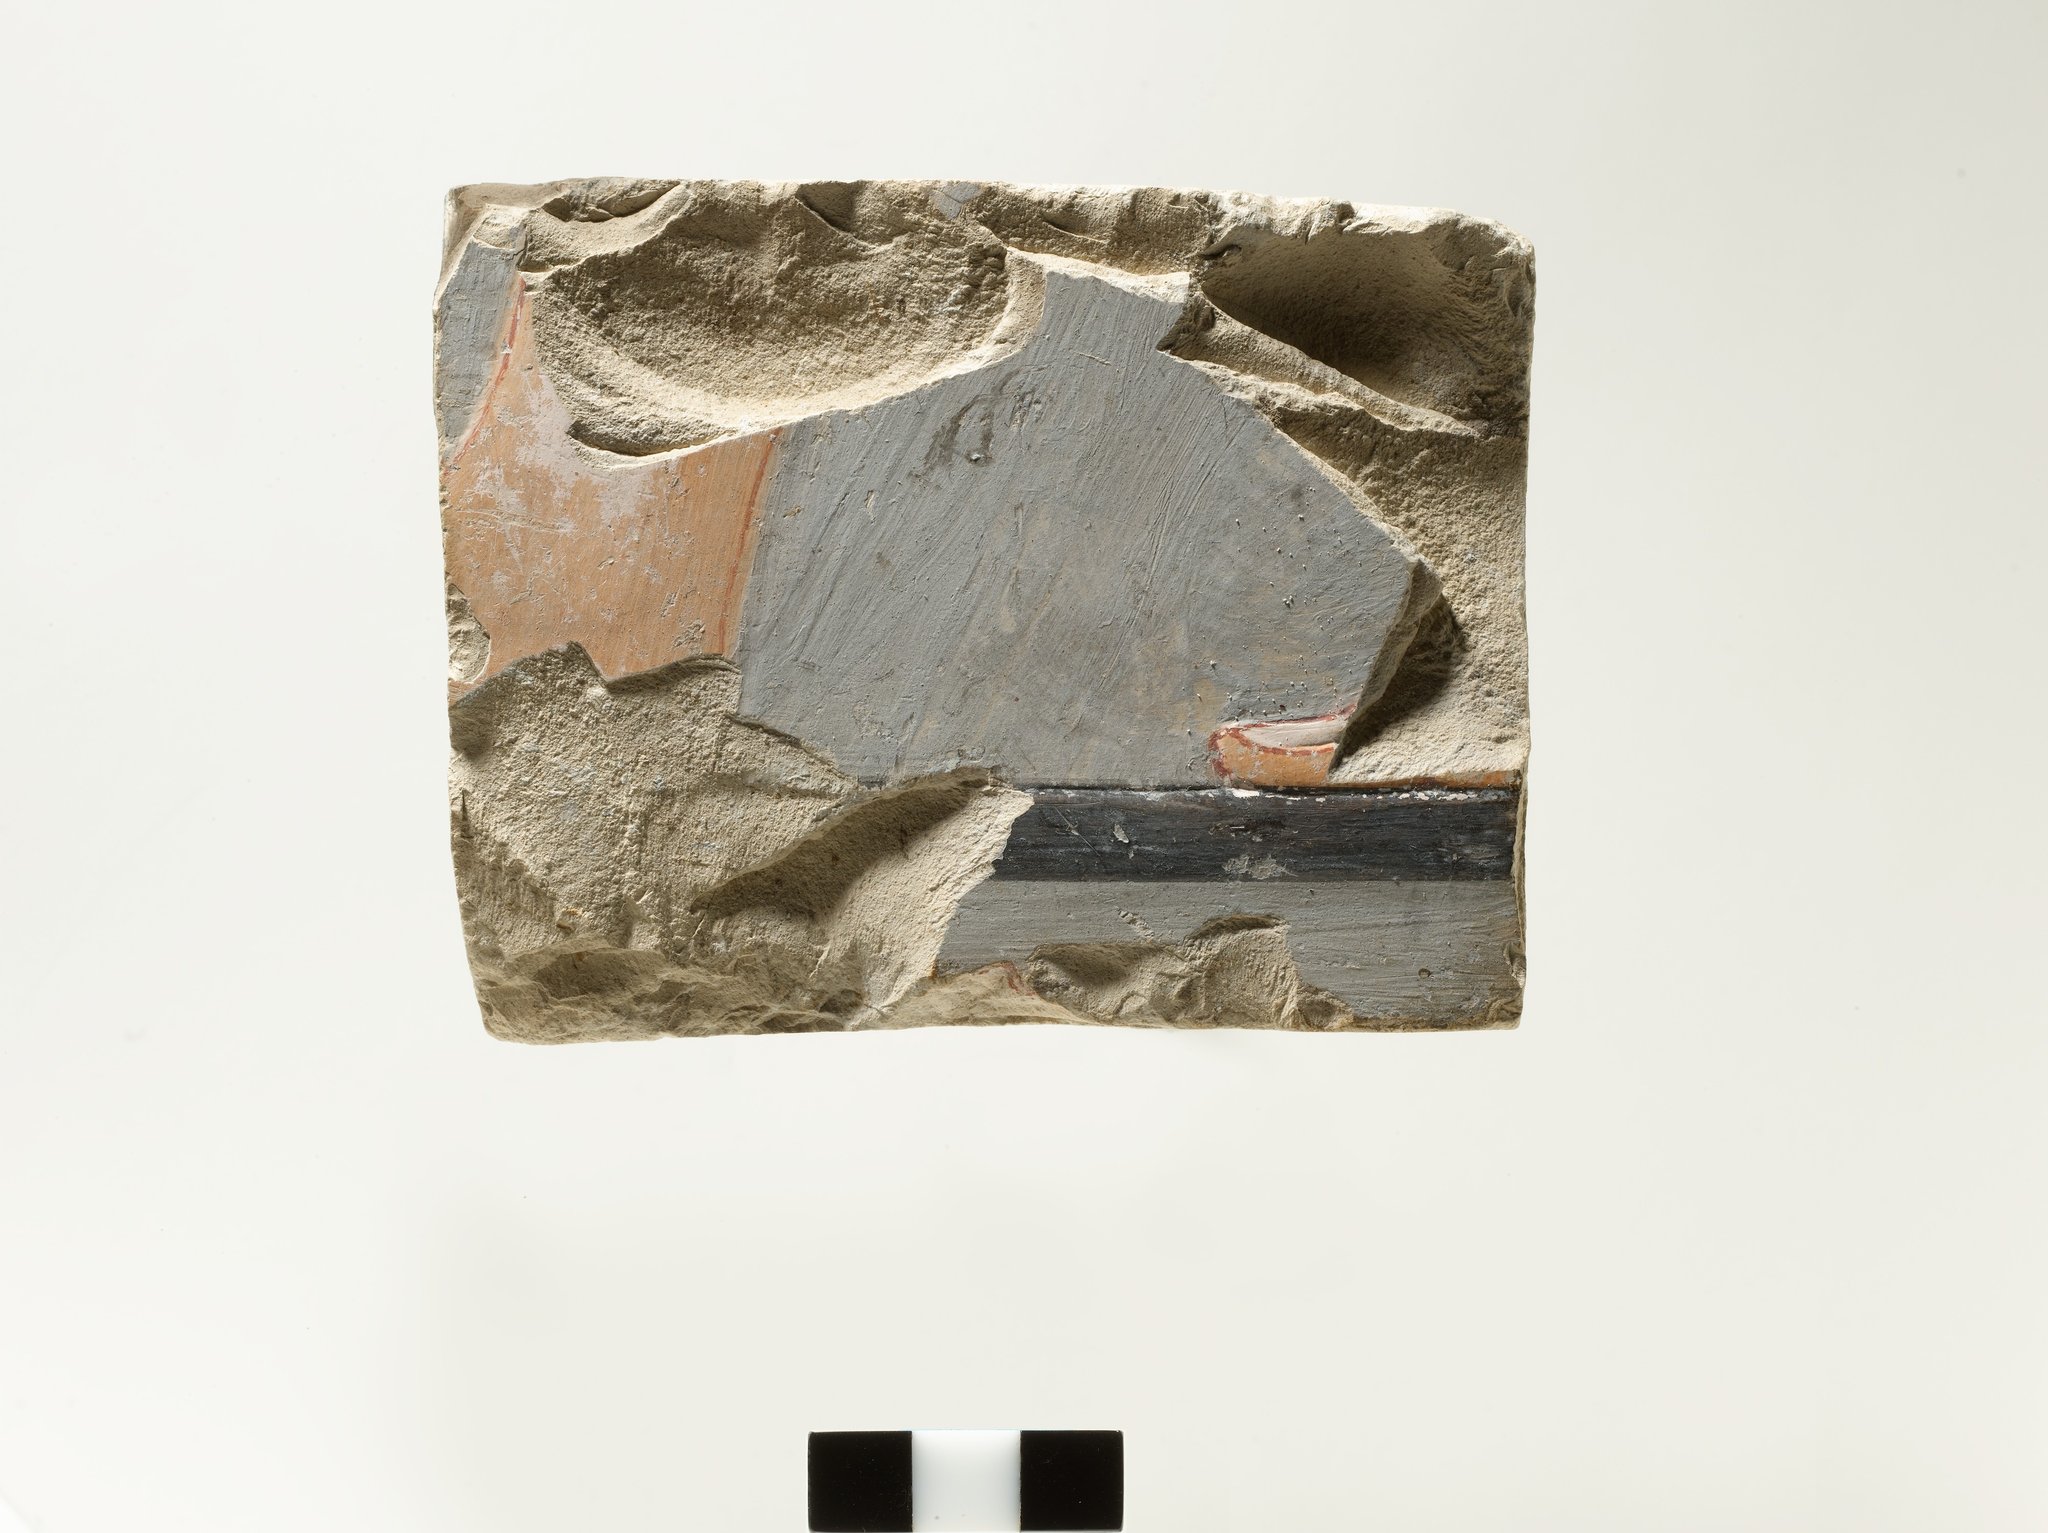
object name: relief fragment, tomb of meketre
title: Reliefs from the tomb of Meketre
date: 1981-1975 BCE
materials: limestone, paint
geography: egypt